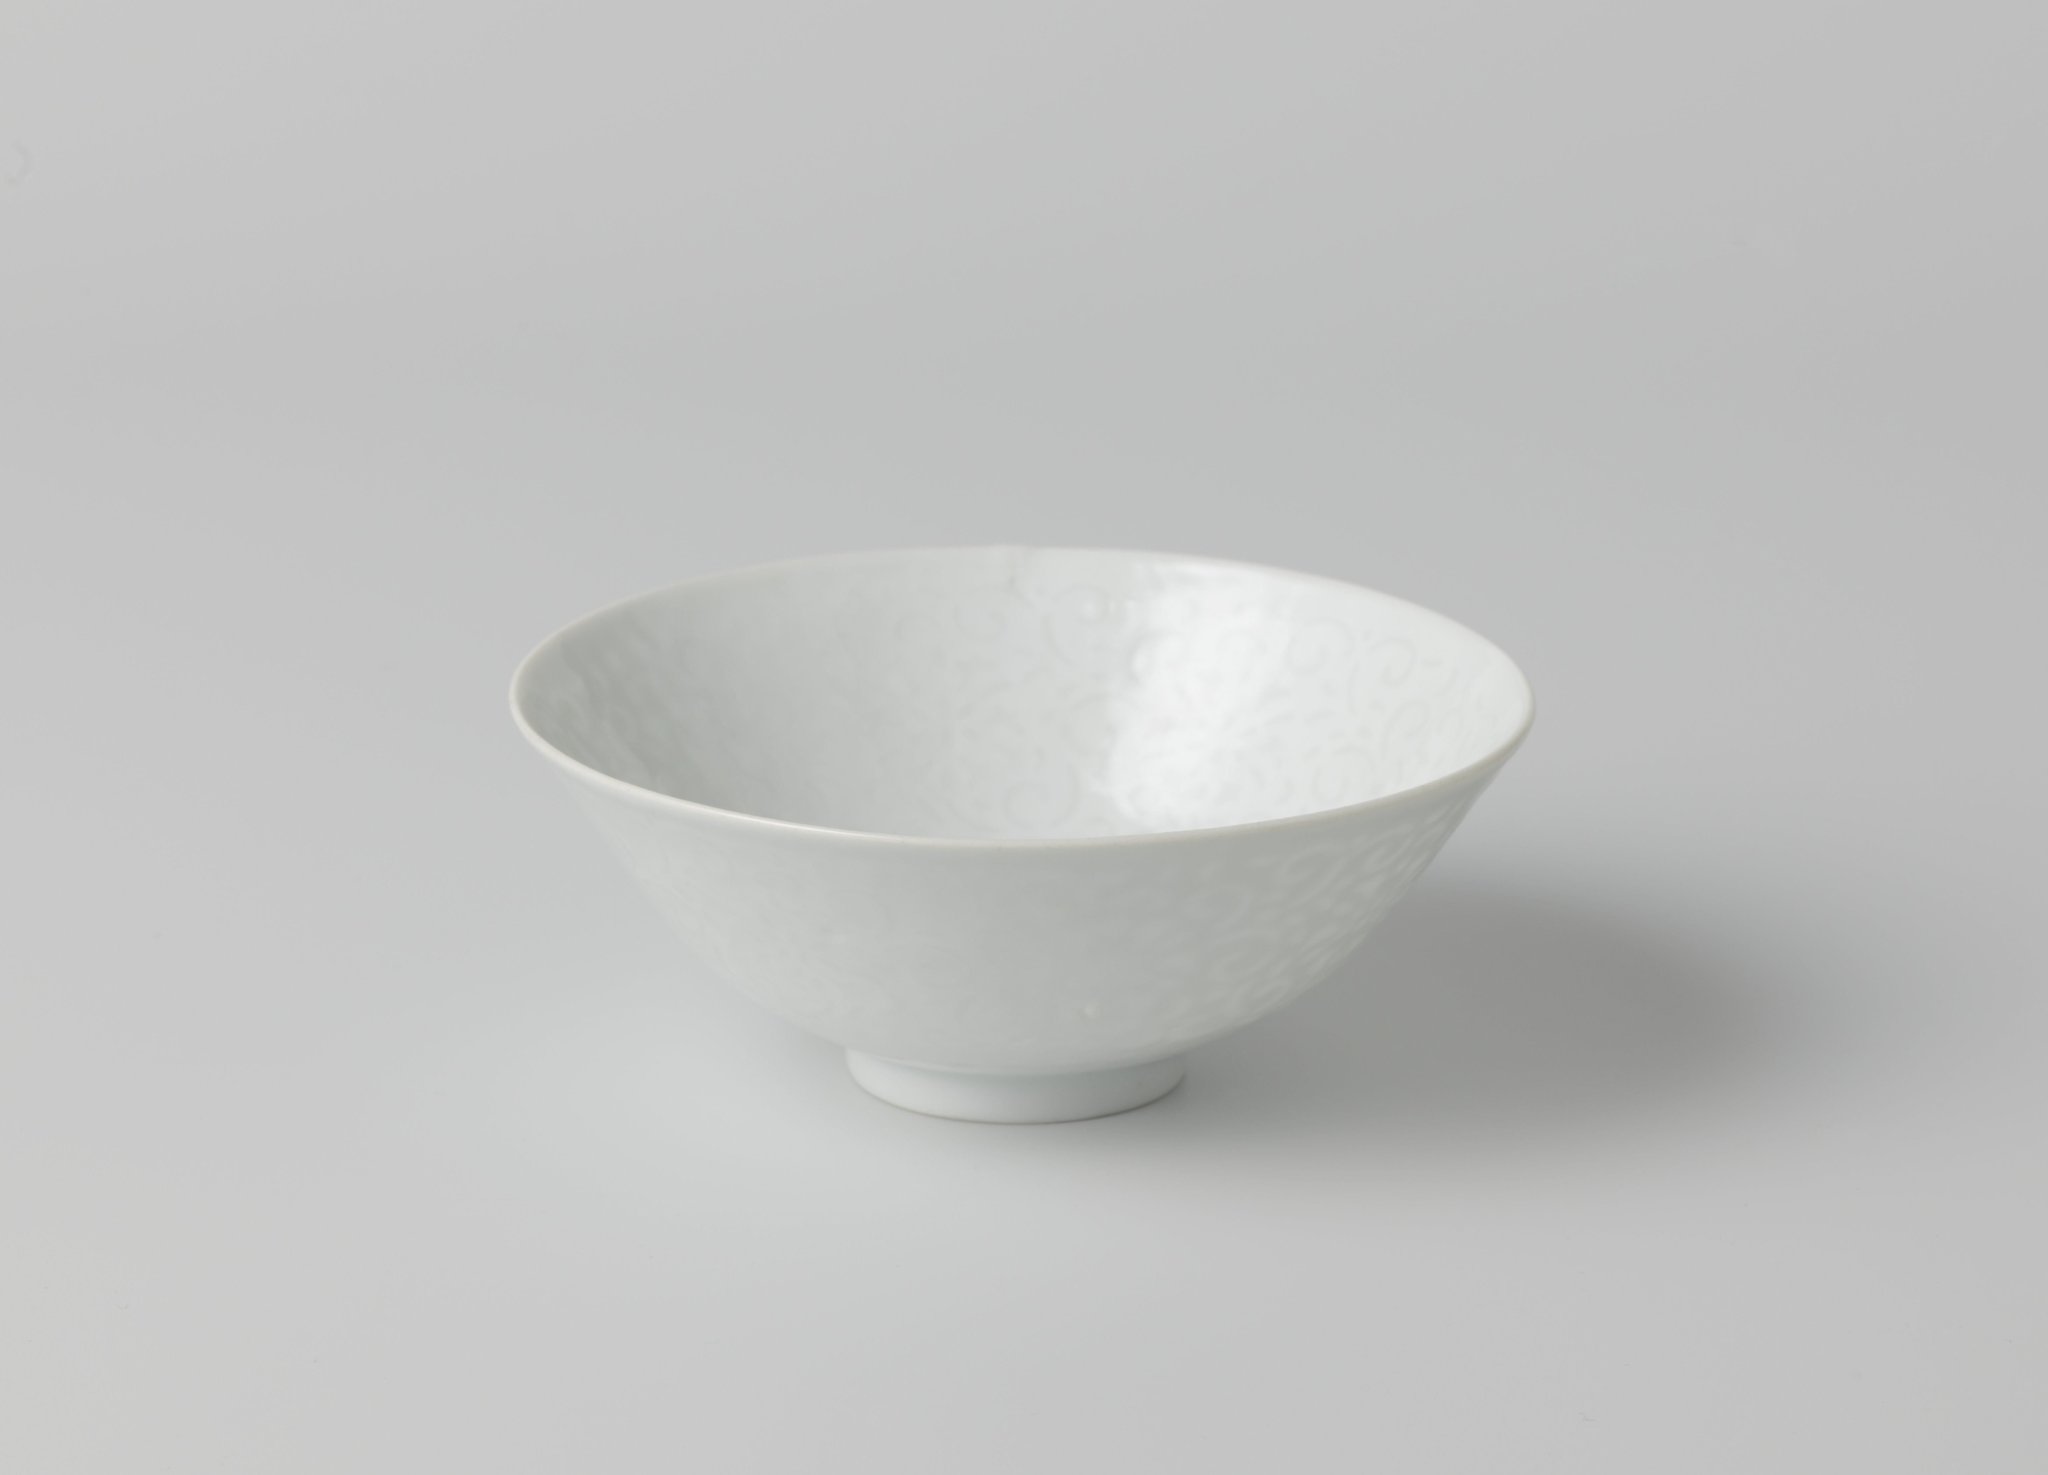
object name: bowl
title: Bowl with translucent flower scrolls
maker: Anonymous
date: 1900-1936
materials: glaze, porcelain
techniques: embroidery, firing, turning, vitrification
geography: dehua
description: Wijde kom van porselein, bedekt met een doorschijnend wit glazuur. De wanden zijn opengewerkt (ajourwerk) met bloemranken, waarover de glazuur is aangebracht. Blanc de Chine.